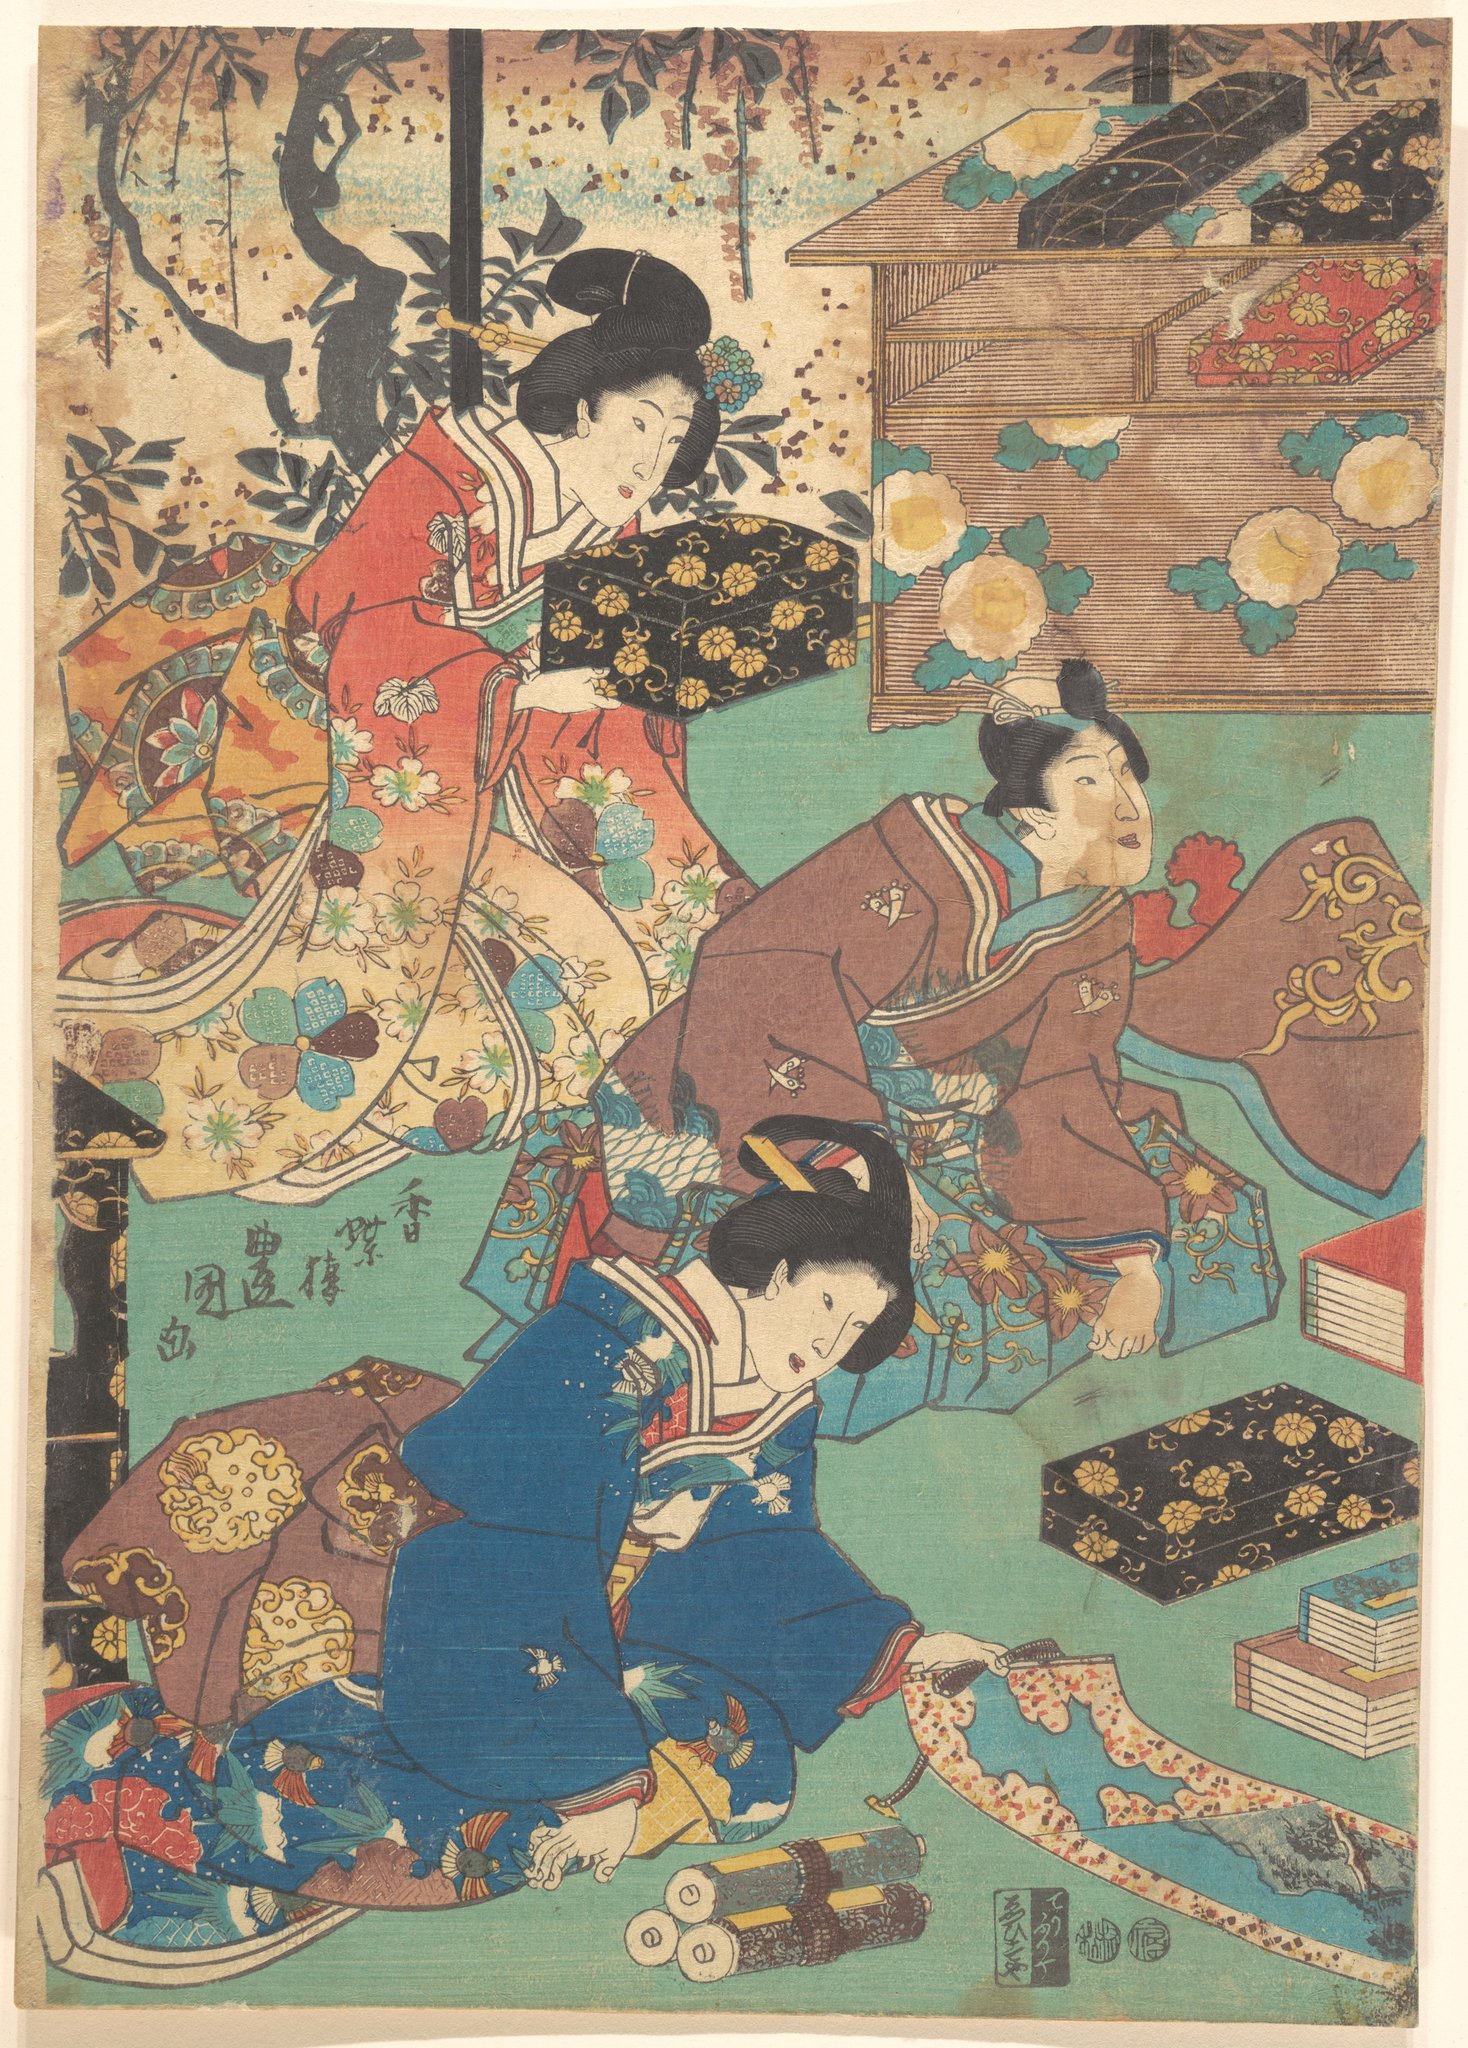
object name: print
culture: japanese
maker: utagawa kunisada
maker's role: artist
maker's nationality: japanese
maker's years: 1786-1864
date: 1786-1854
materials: ink, paper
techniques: woodblock print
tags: scrolls,women,trees,furniture